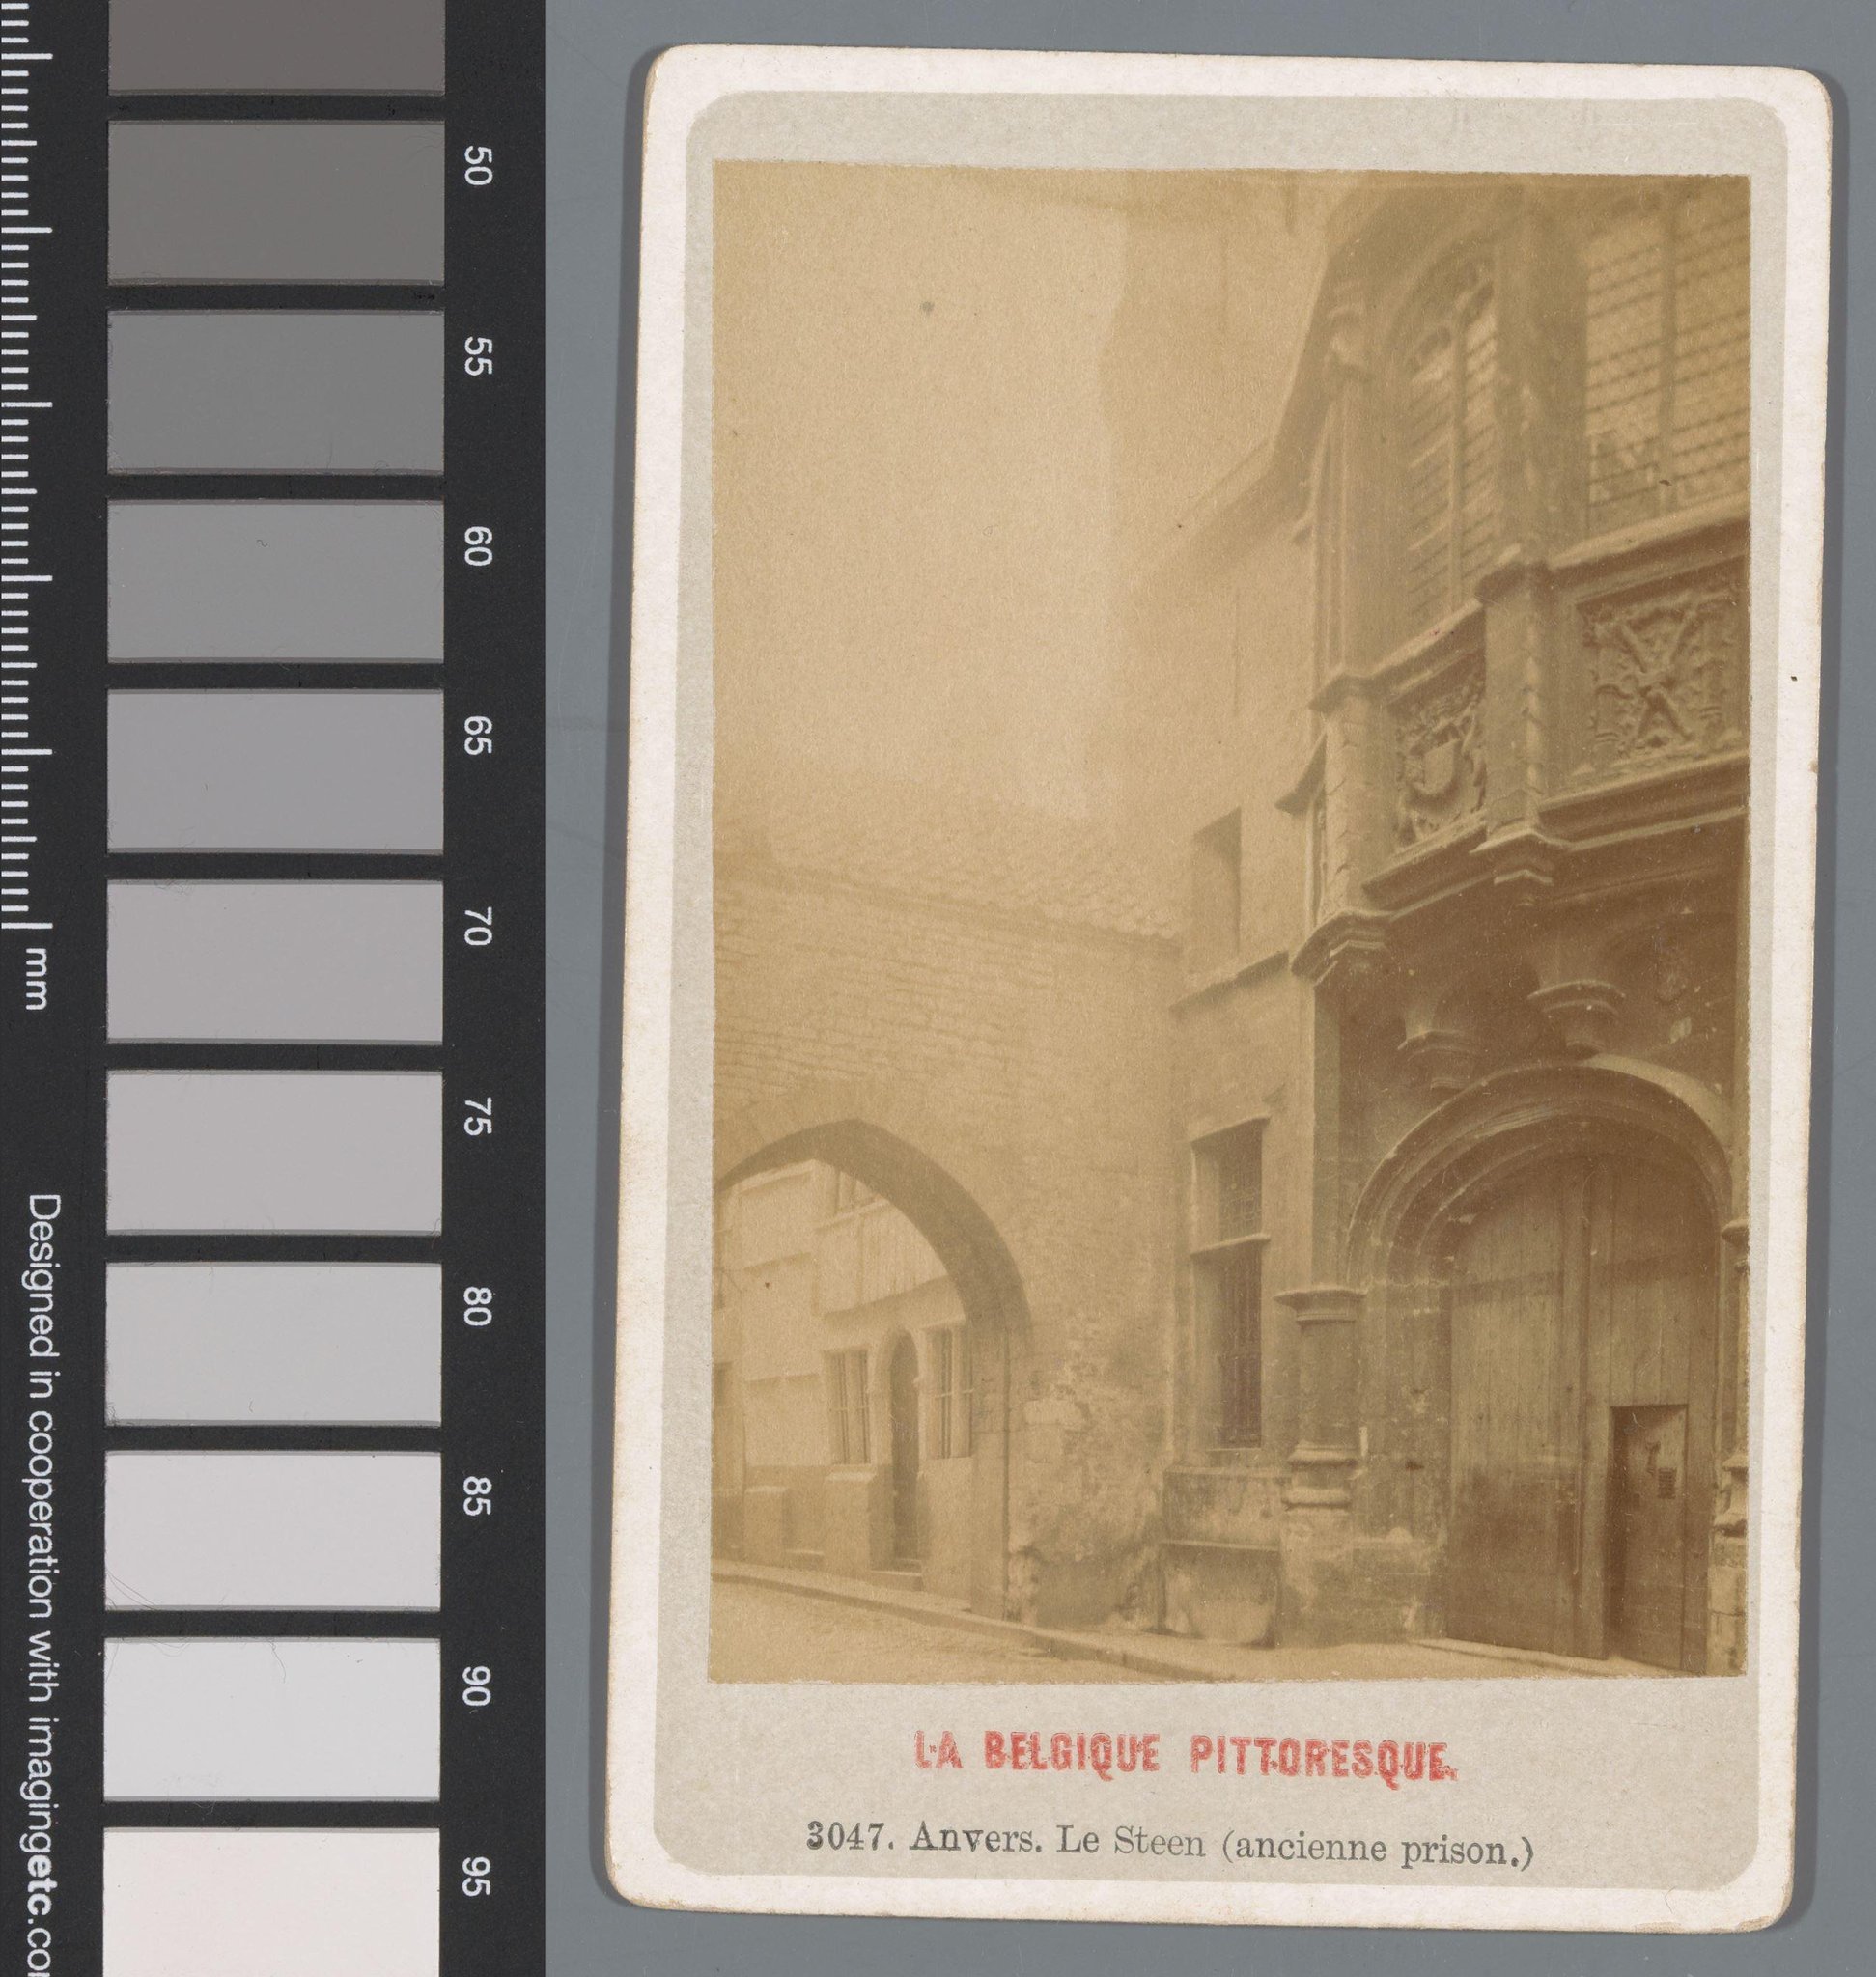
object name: photograph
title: Anvers. Le Steen (ancienne prison.)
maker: Anonymous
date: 1866-1906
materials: cardboard, paper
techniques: albumen print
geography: antwerp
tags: castle, bay-window, oriel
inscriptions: inscription: ‘Ancienne maison F. Tessaro/ G. Zazzarini & Cie, Successeurs/ 37, Marché aux Souliers/ Anvers’, number: ‘3047.’